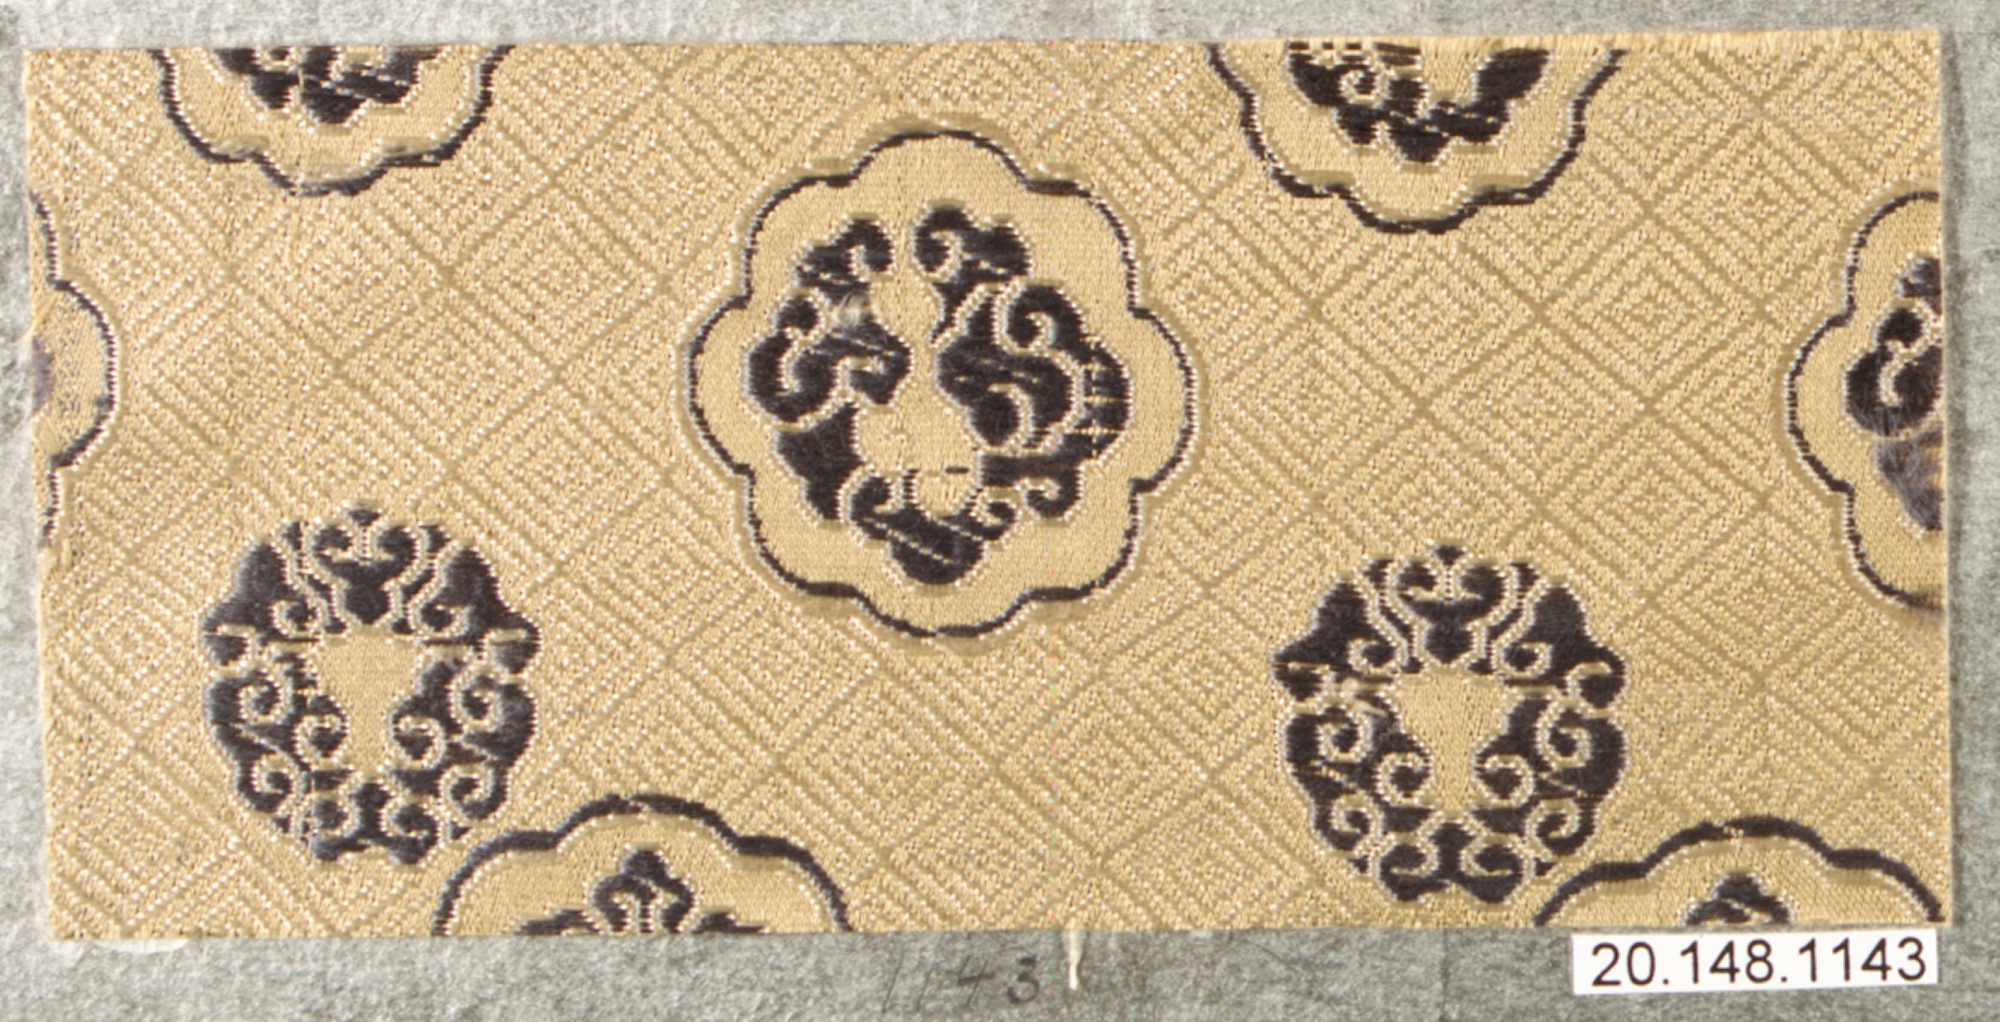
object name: piece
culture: japanese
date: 1801-1900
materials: silk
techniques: compound weave